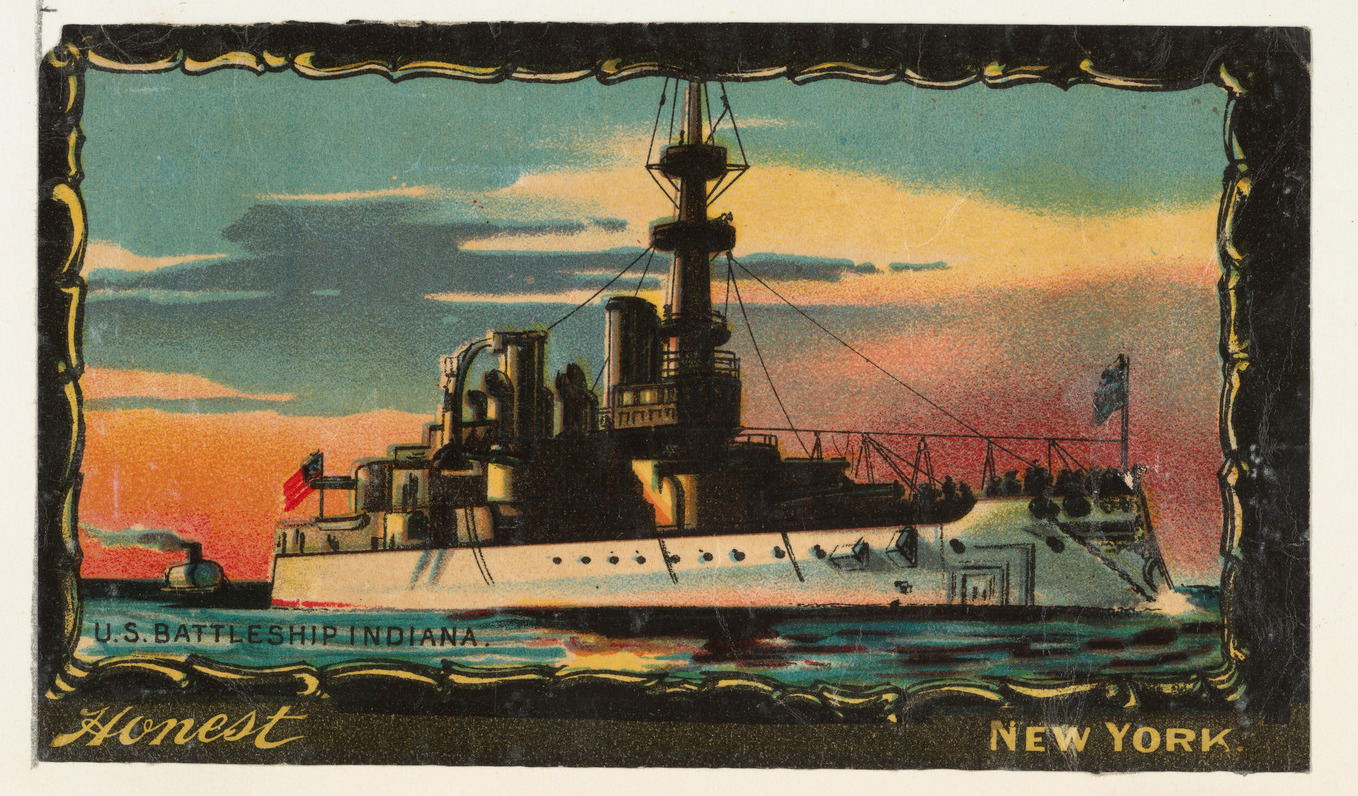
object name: print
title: U.S. Battleship Indiana, from the Transparencies series (N137) issued by W. Duke, Sons & Co. to promote Honest Long Cut Tobacco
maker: w. duke, sons & co.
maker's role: publisher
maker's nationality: american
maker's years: 1870-1920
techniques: color lithograph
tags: ships